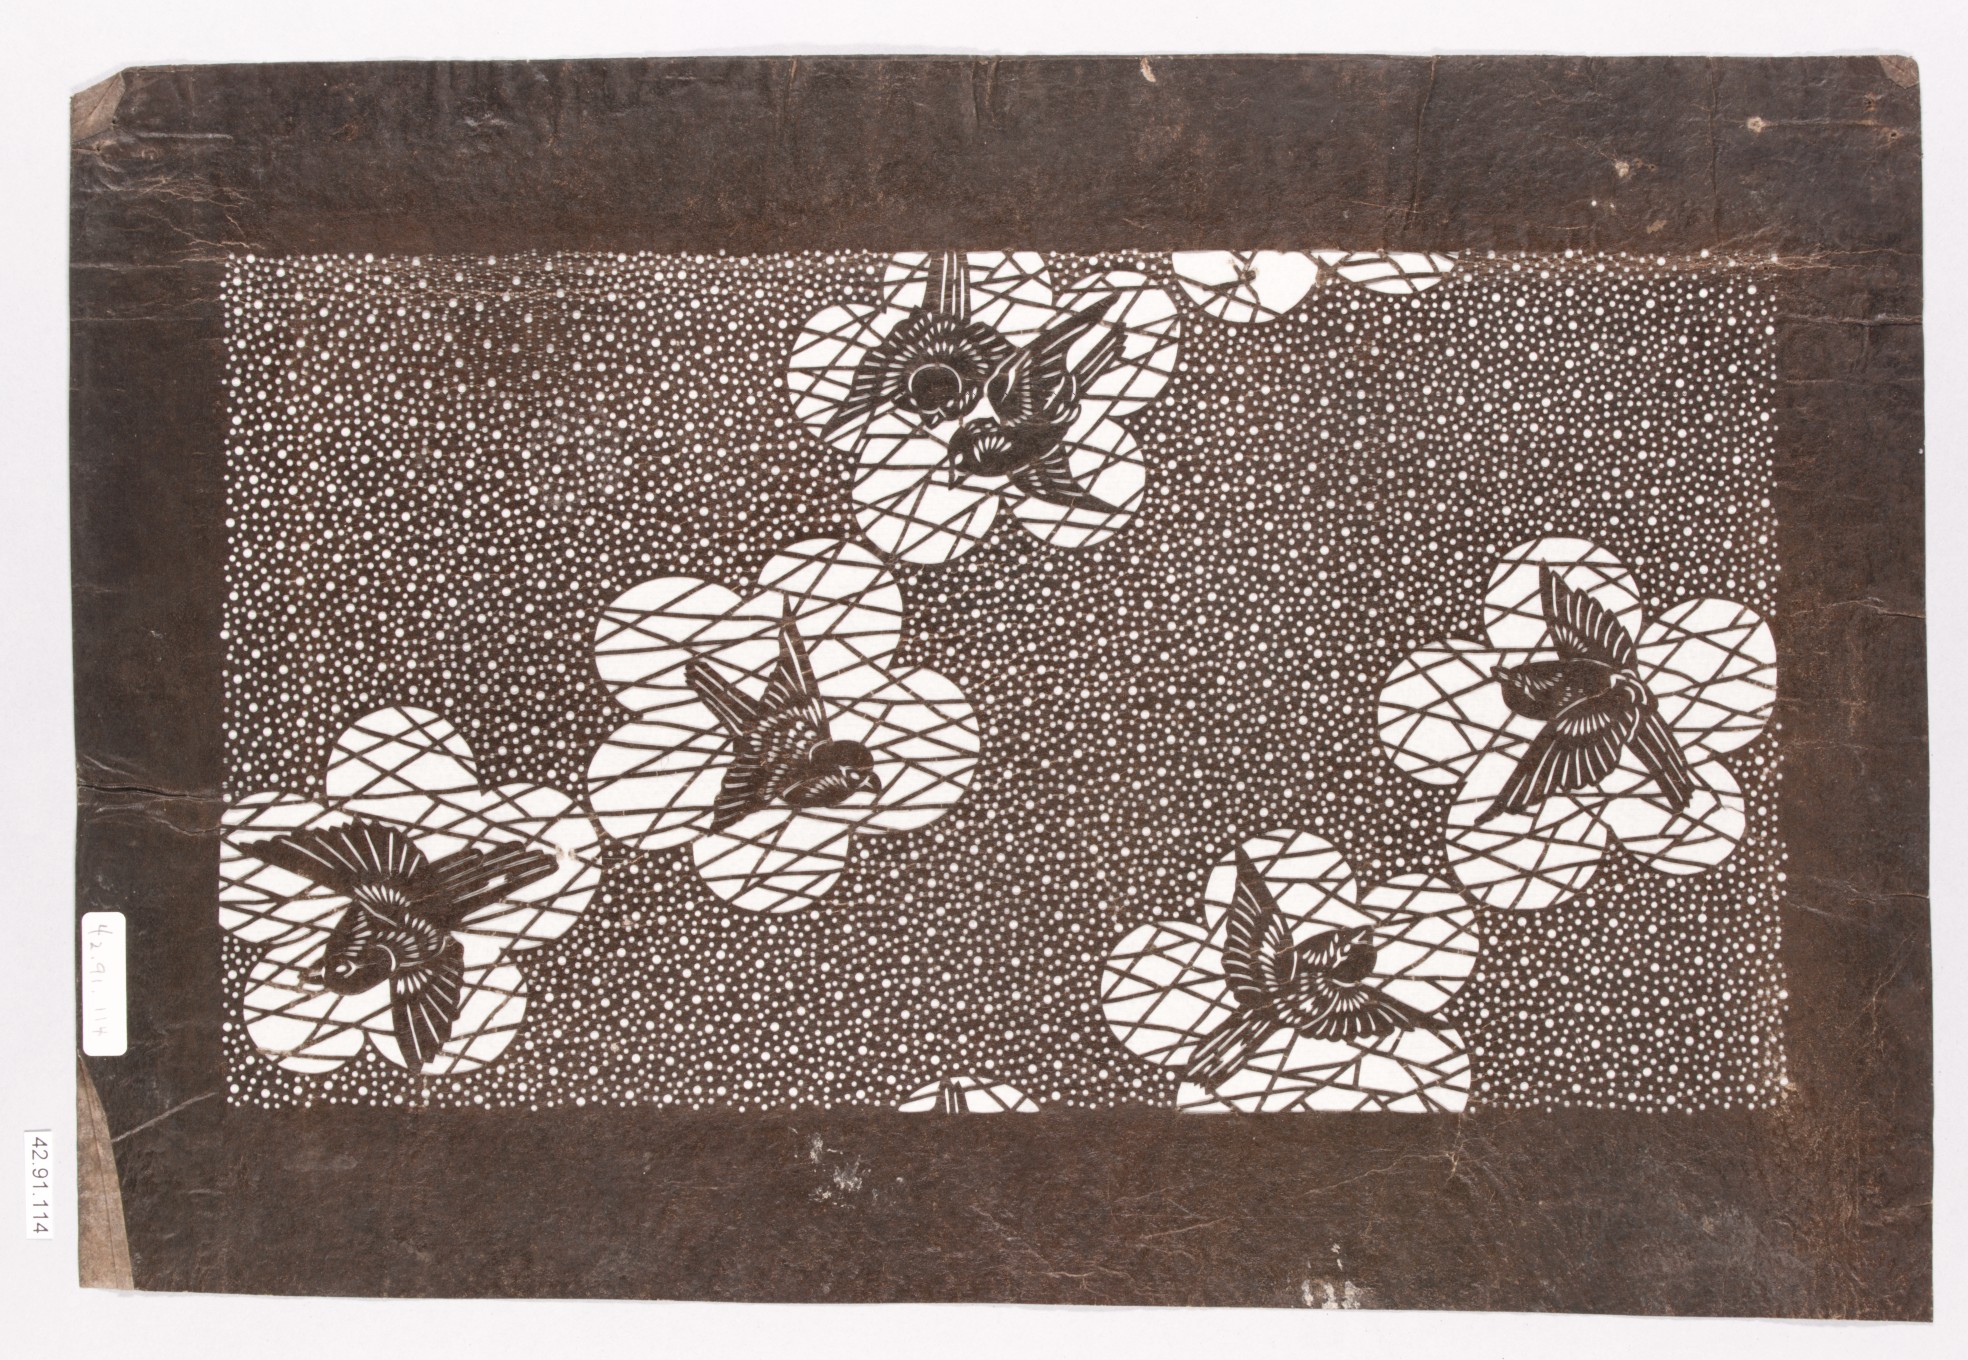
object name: stencil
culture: japanese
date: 1801-1900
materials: paper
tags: birds